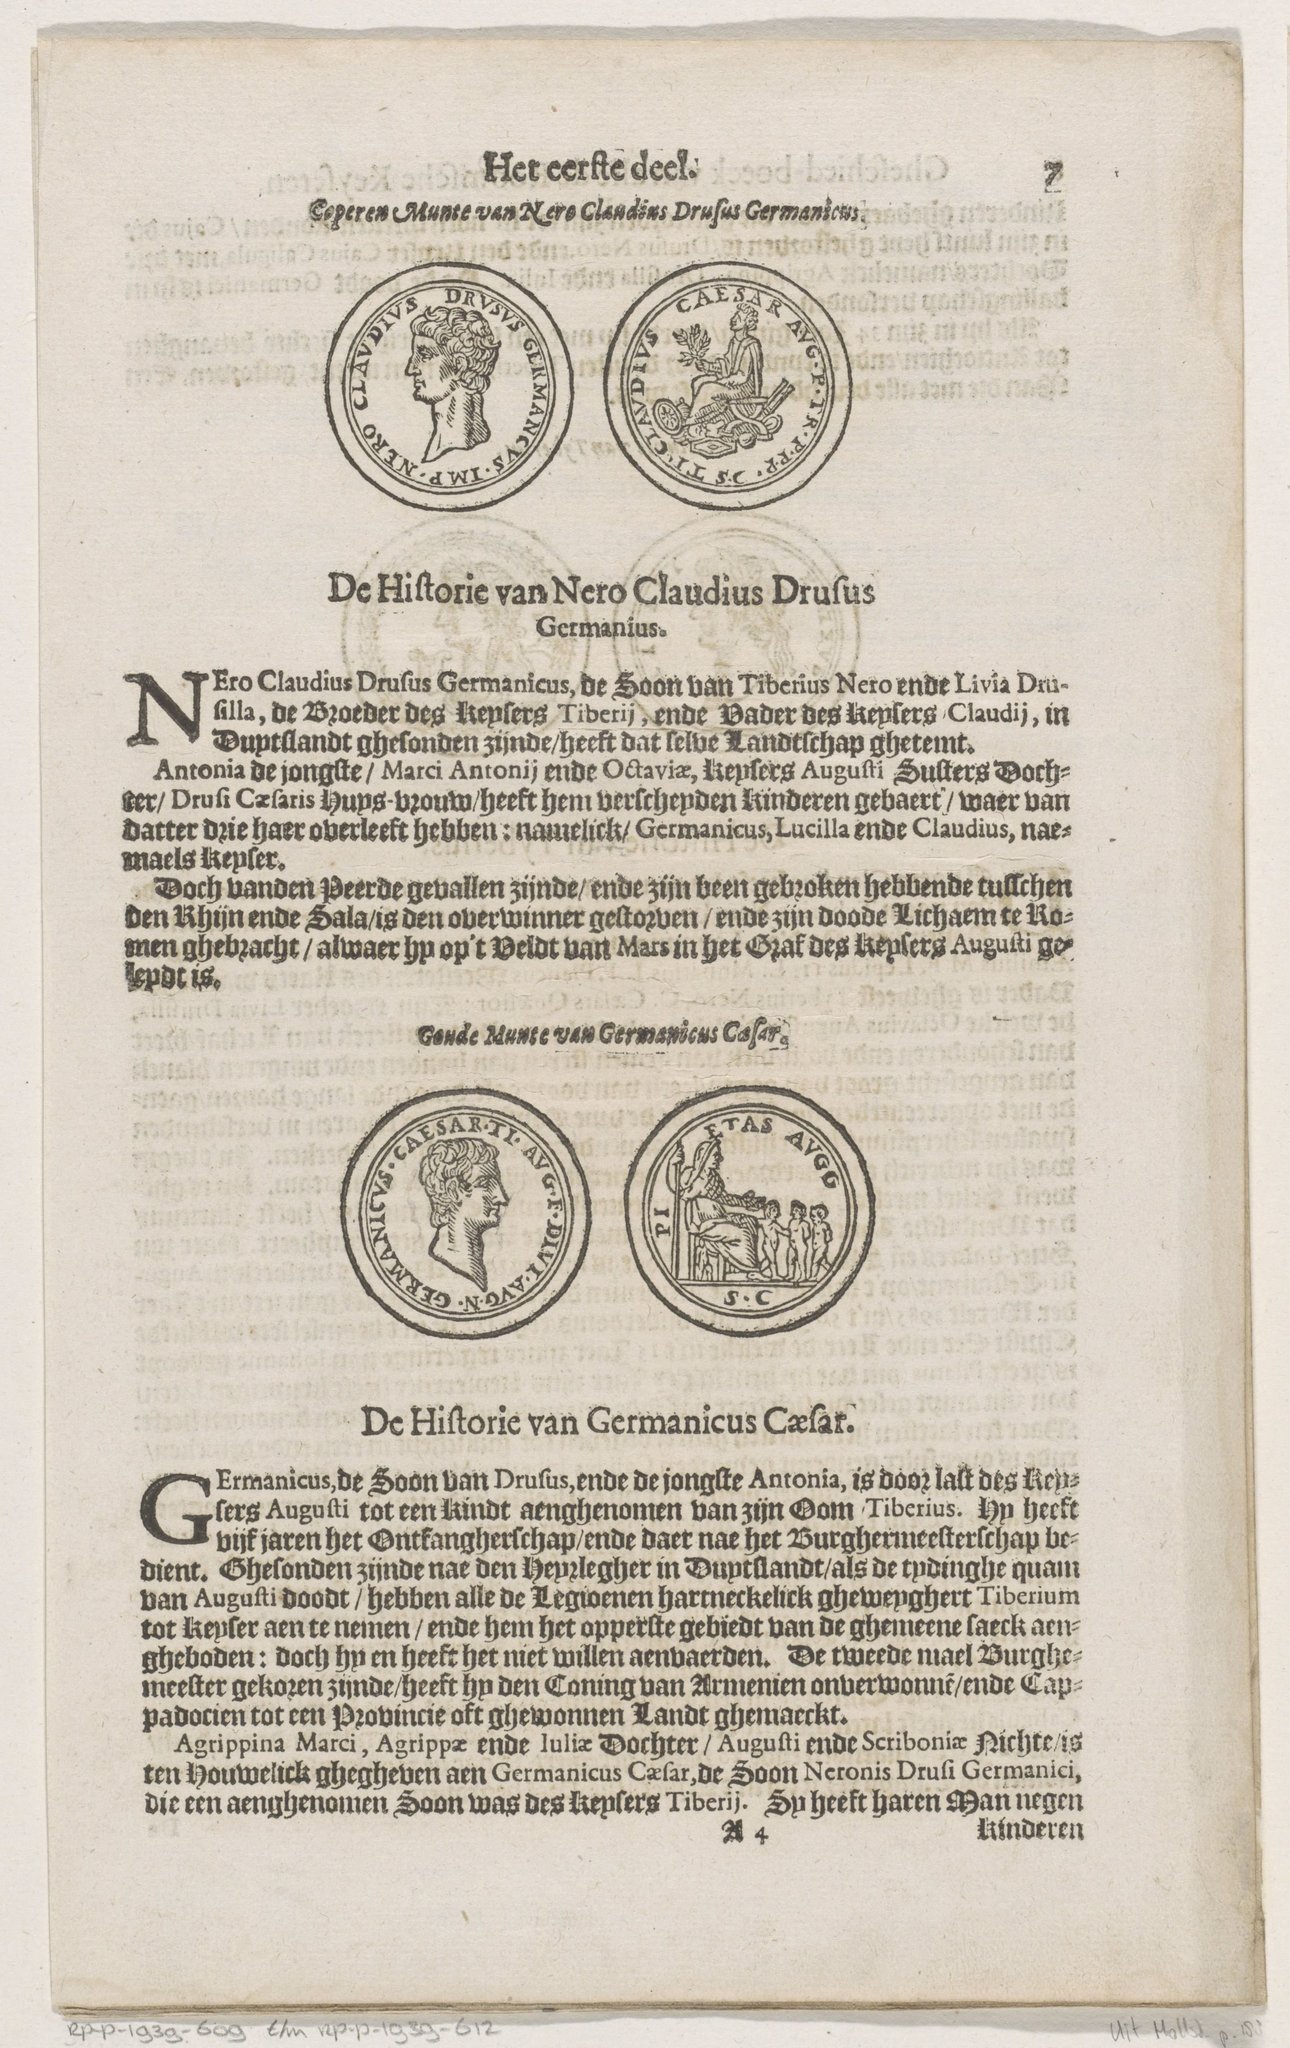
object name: book illustration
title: Penningen met portretten van keizer Nero Claudius Drusus Germanicus, keizer Germanicus Caesar en keizer Tyberius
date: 1617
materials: paper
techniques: letterpress printing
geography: amsterdam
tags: emperor, coin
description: Prent uit: Georgius Chanler. Nieuwe keysers chronica ofte Gheschicht-boeck van alle de roomsche, soo oostersche als westersche keyseren. Amsterdam: Nicolaes Biestkens, 1617.